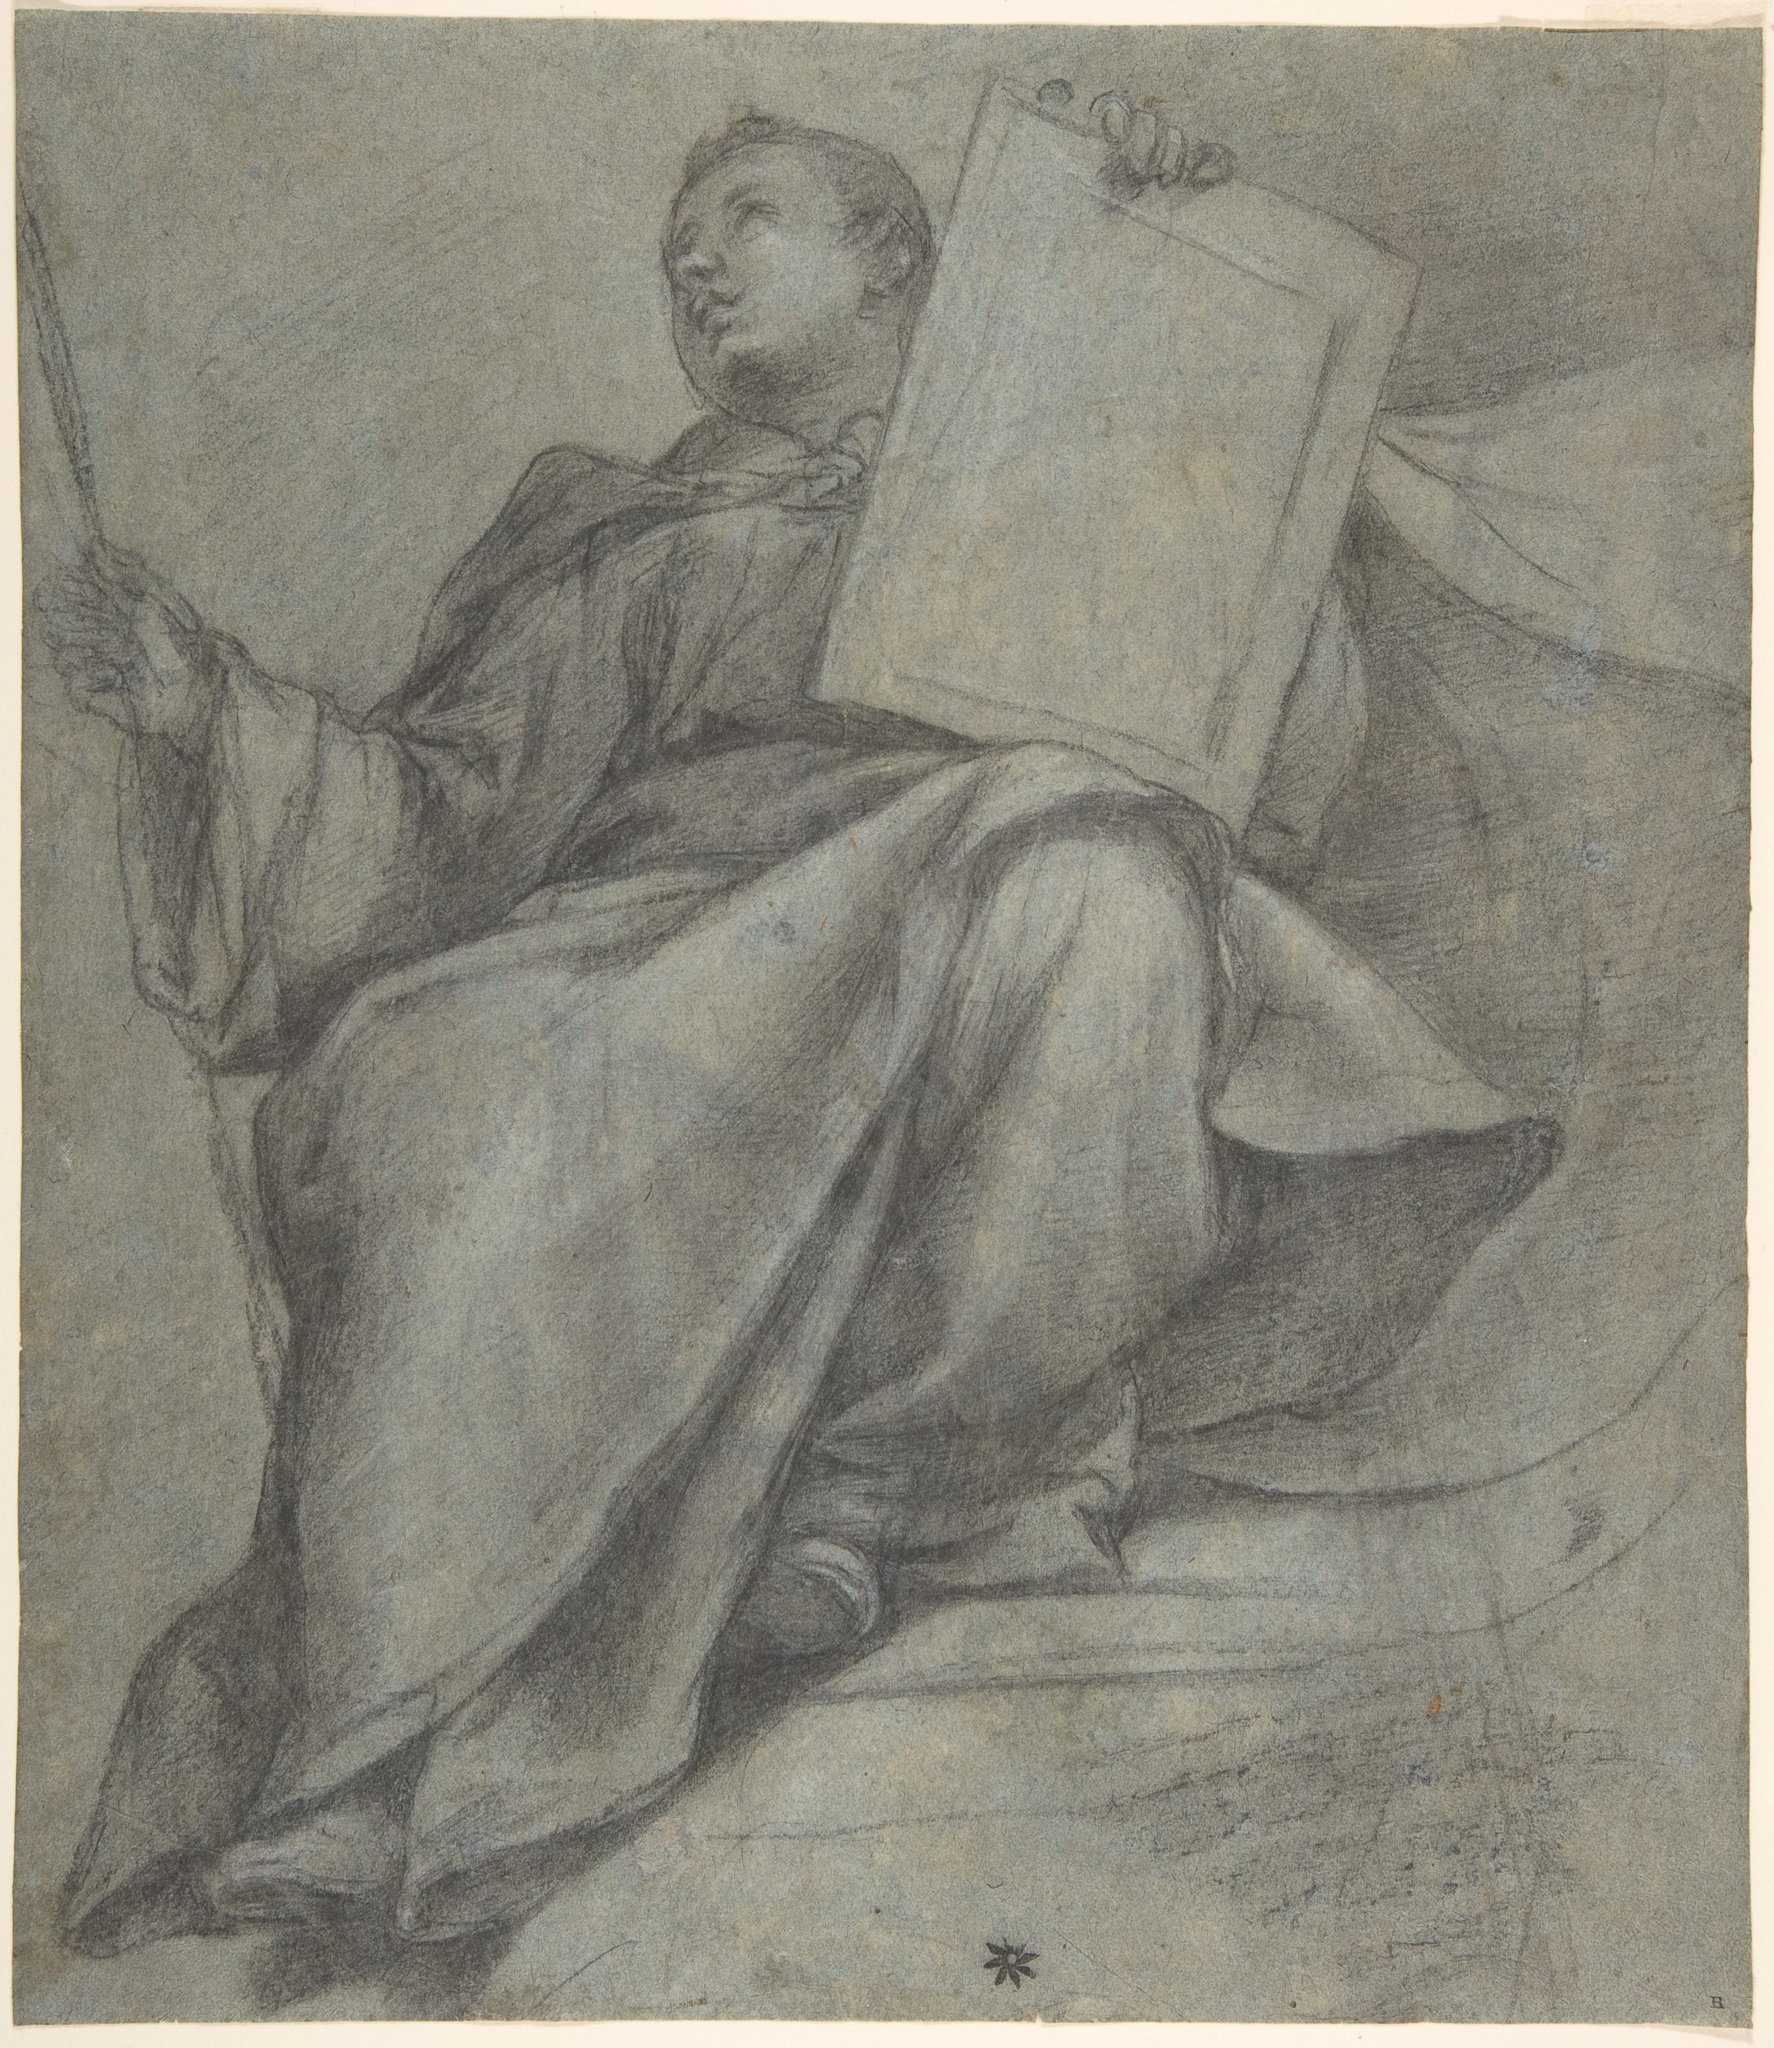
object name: drawing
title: Seated Monk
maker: denijs calvaert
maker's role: artist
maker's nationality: netherlandish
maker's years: 1540-1619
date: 1534-1633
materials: chalk, paper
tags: monks